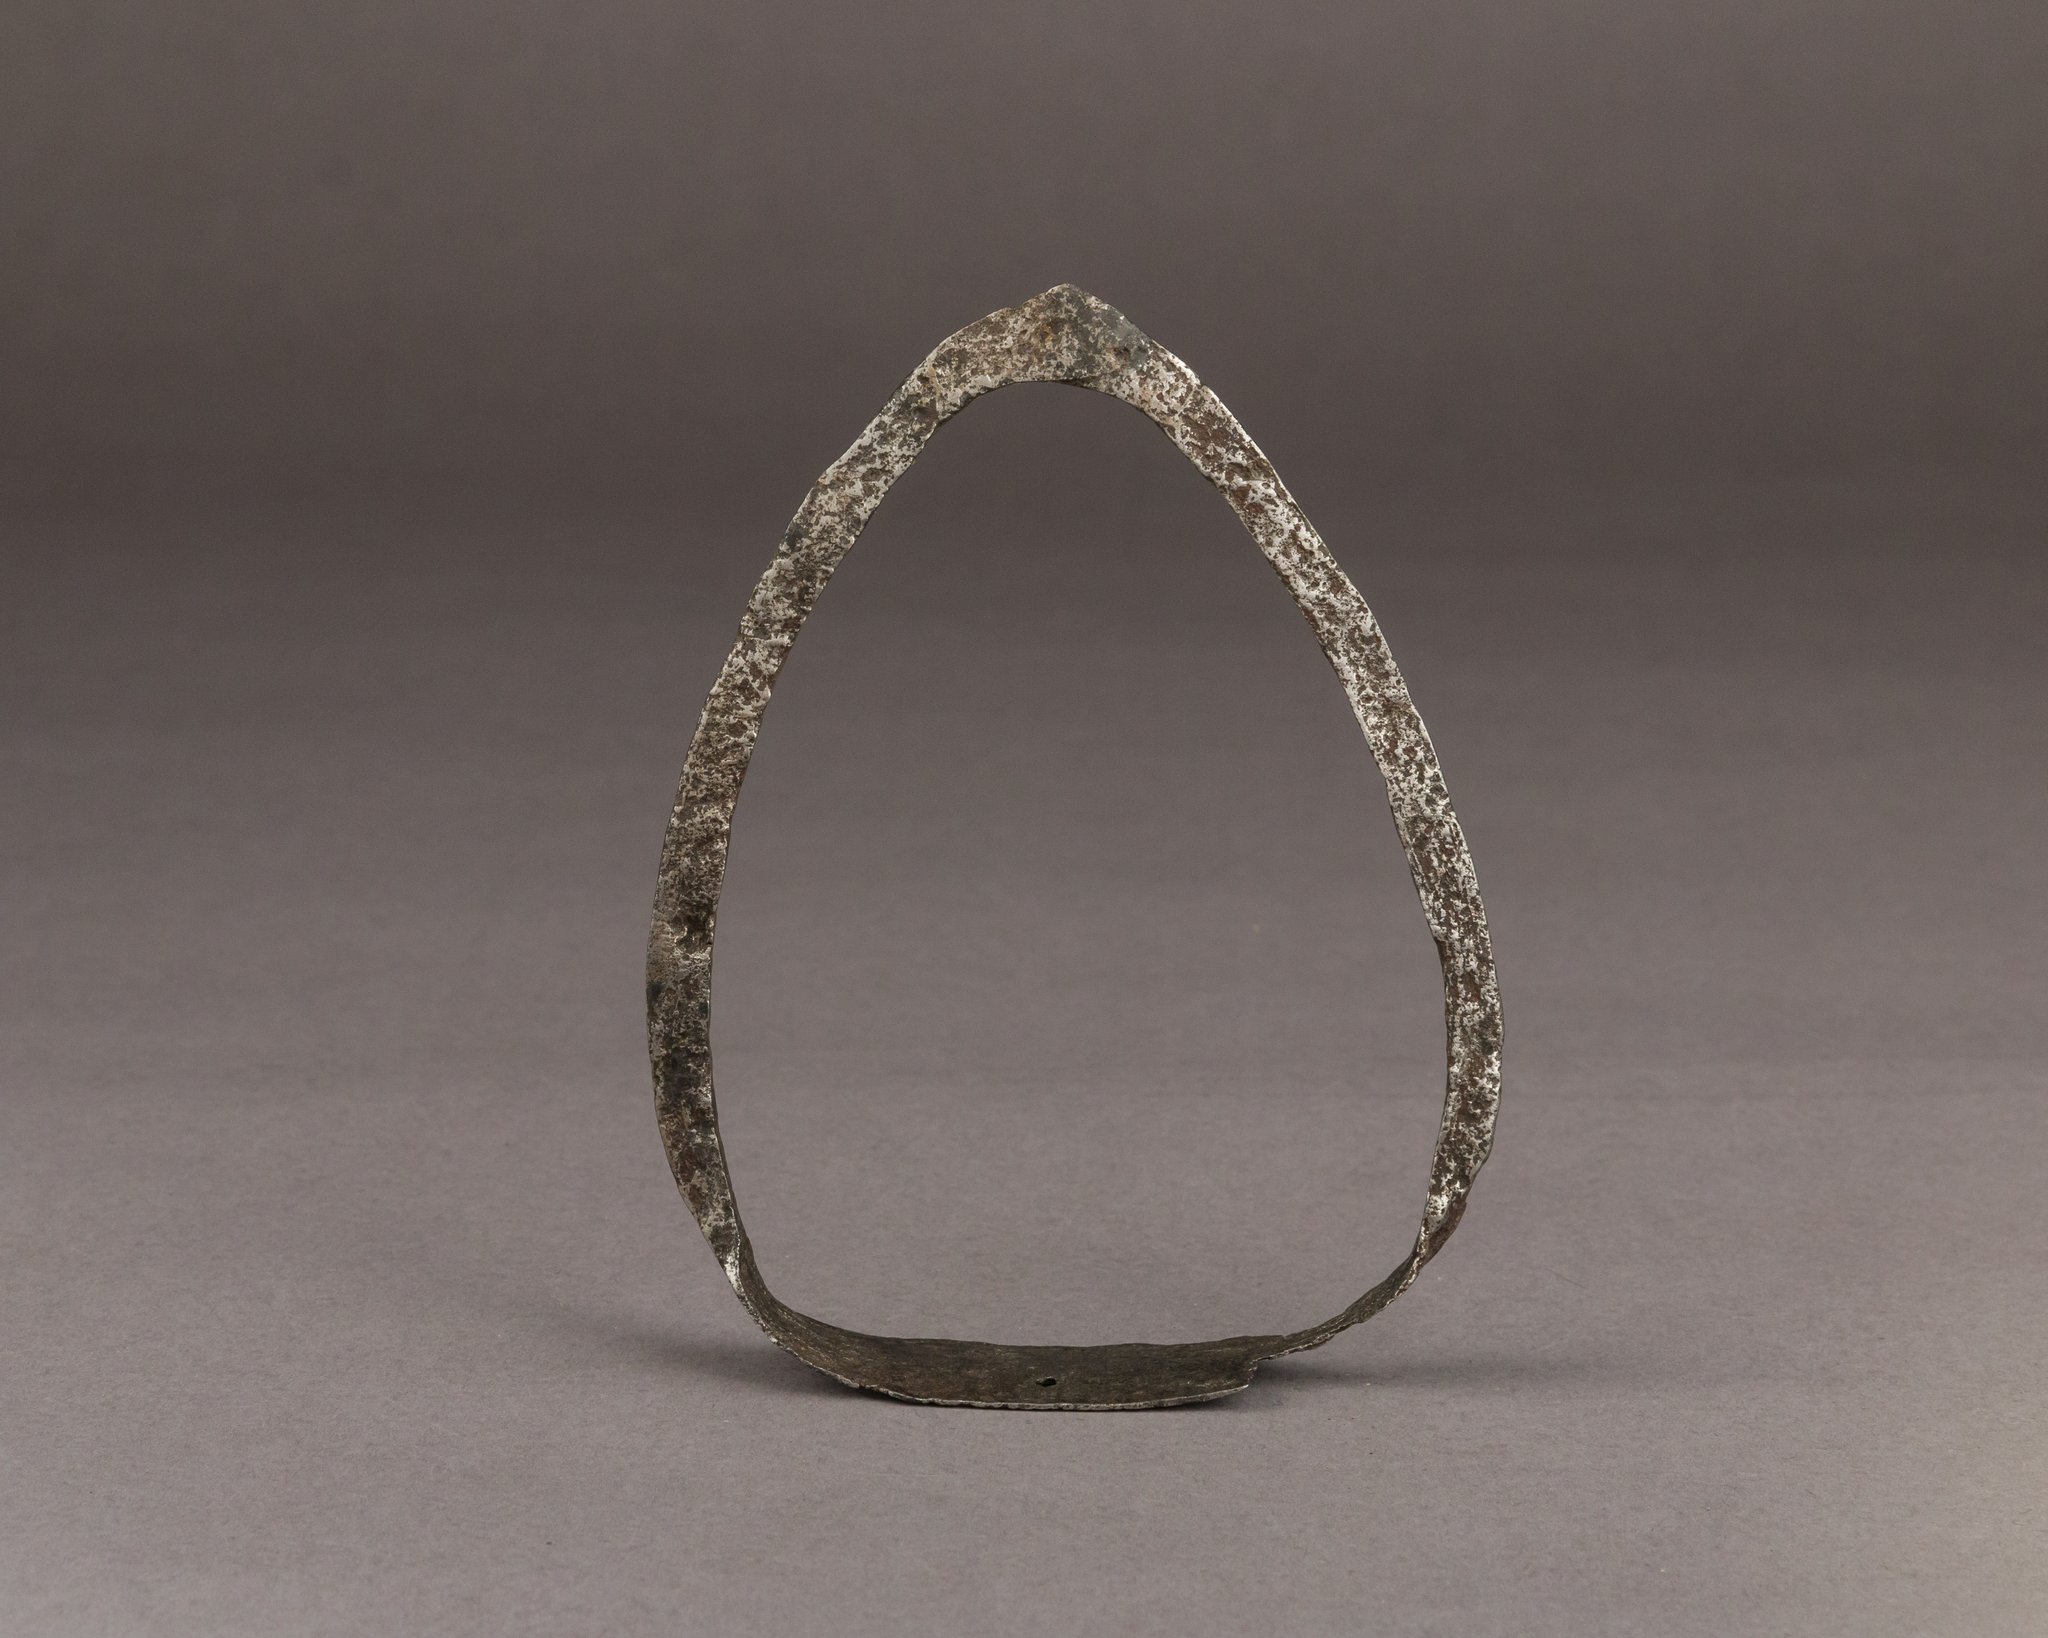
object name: stirrup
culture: west slavic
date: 901-1100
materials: iron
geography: poland